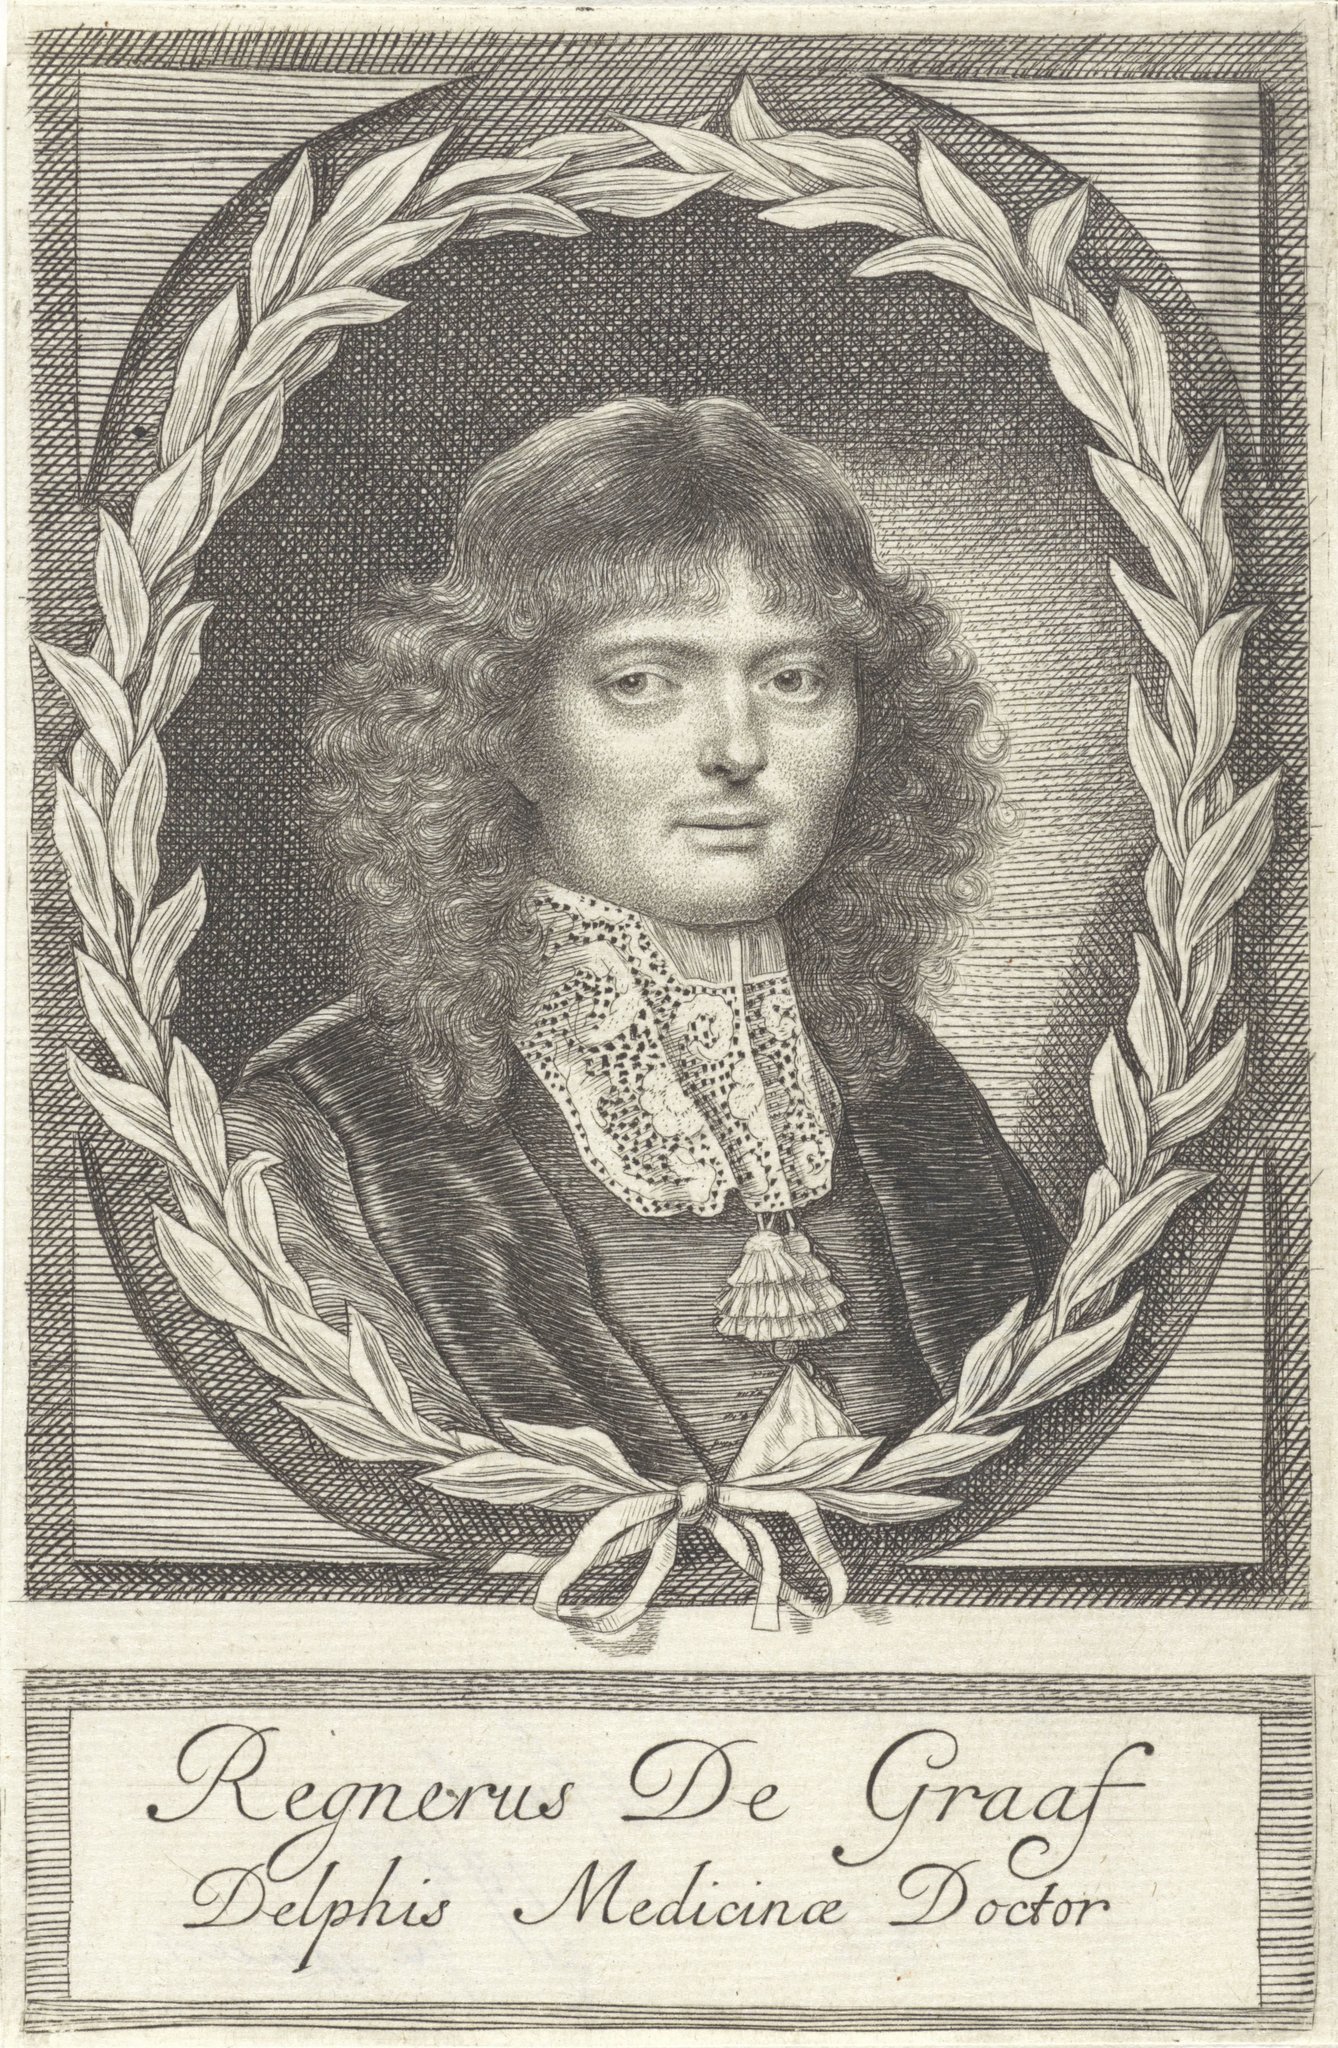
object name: print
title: Portret van Reinier de Graaf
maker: anna maria van schurman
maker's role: draughtsman, print maker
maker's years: 1607-1678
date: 1666-1673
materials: paper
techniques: engraving, etching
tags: reinier de graaf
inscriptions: collector's mark: Lugt 2228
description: Portret van de arts en anatoom Reinier de Graaf.